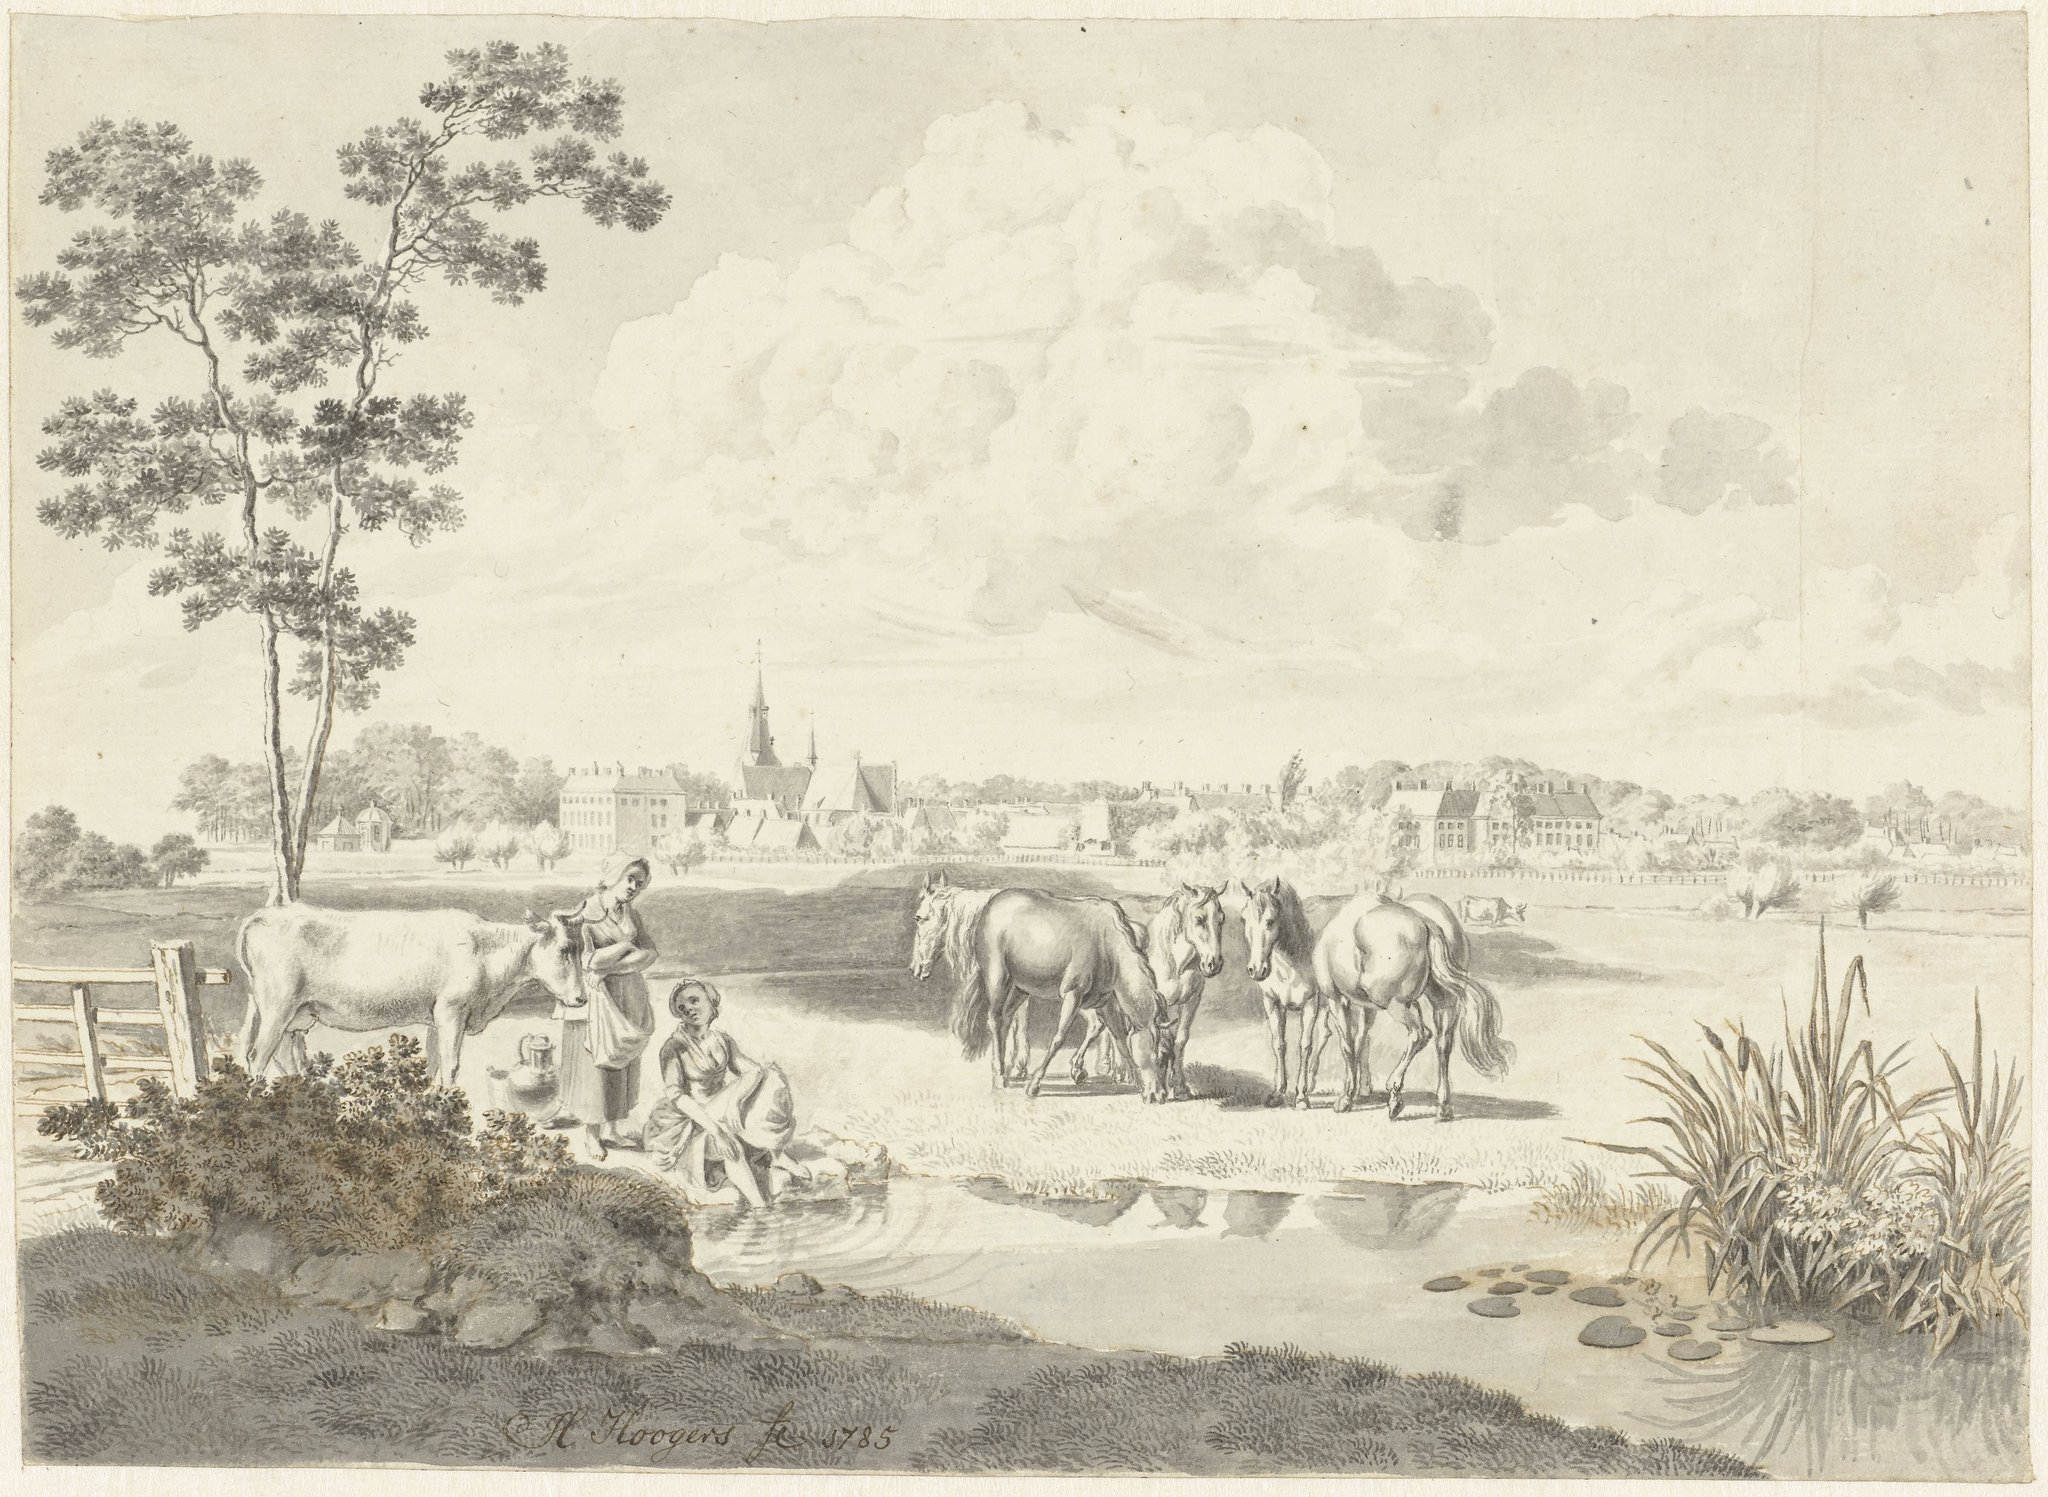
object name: drawing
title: Gezicht op Wageningen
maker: hendrik hoogers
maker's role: draughtsman, mayor, print maker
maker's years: 1747-1814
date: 1785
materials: ink, paper, pencil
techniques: brush, pen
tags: prospect of city, town panorama, silhouette of city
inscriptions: inscription: ‘Wageninge uijt de wijlanden te sien’